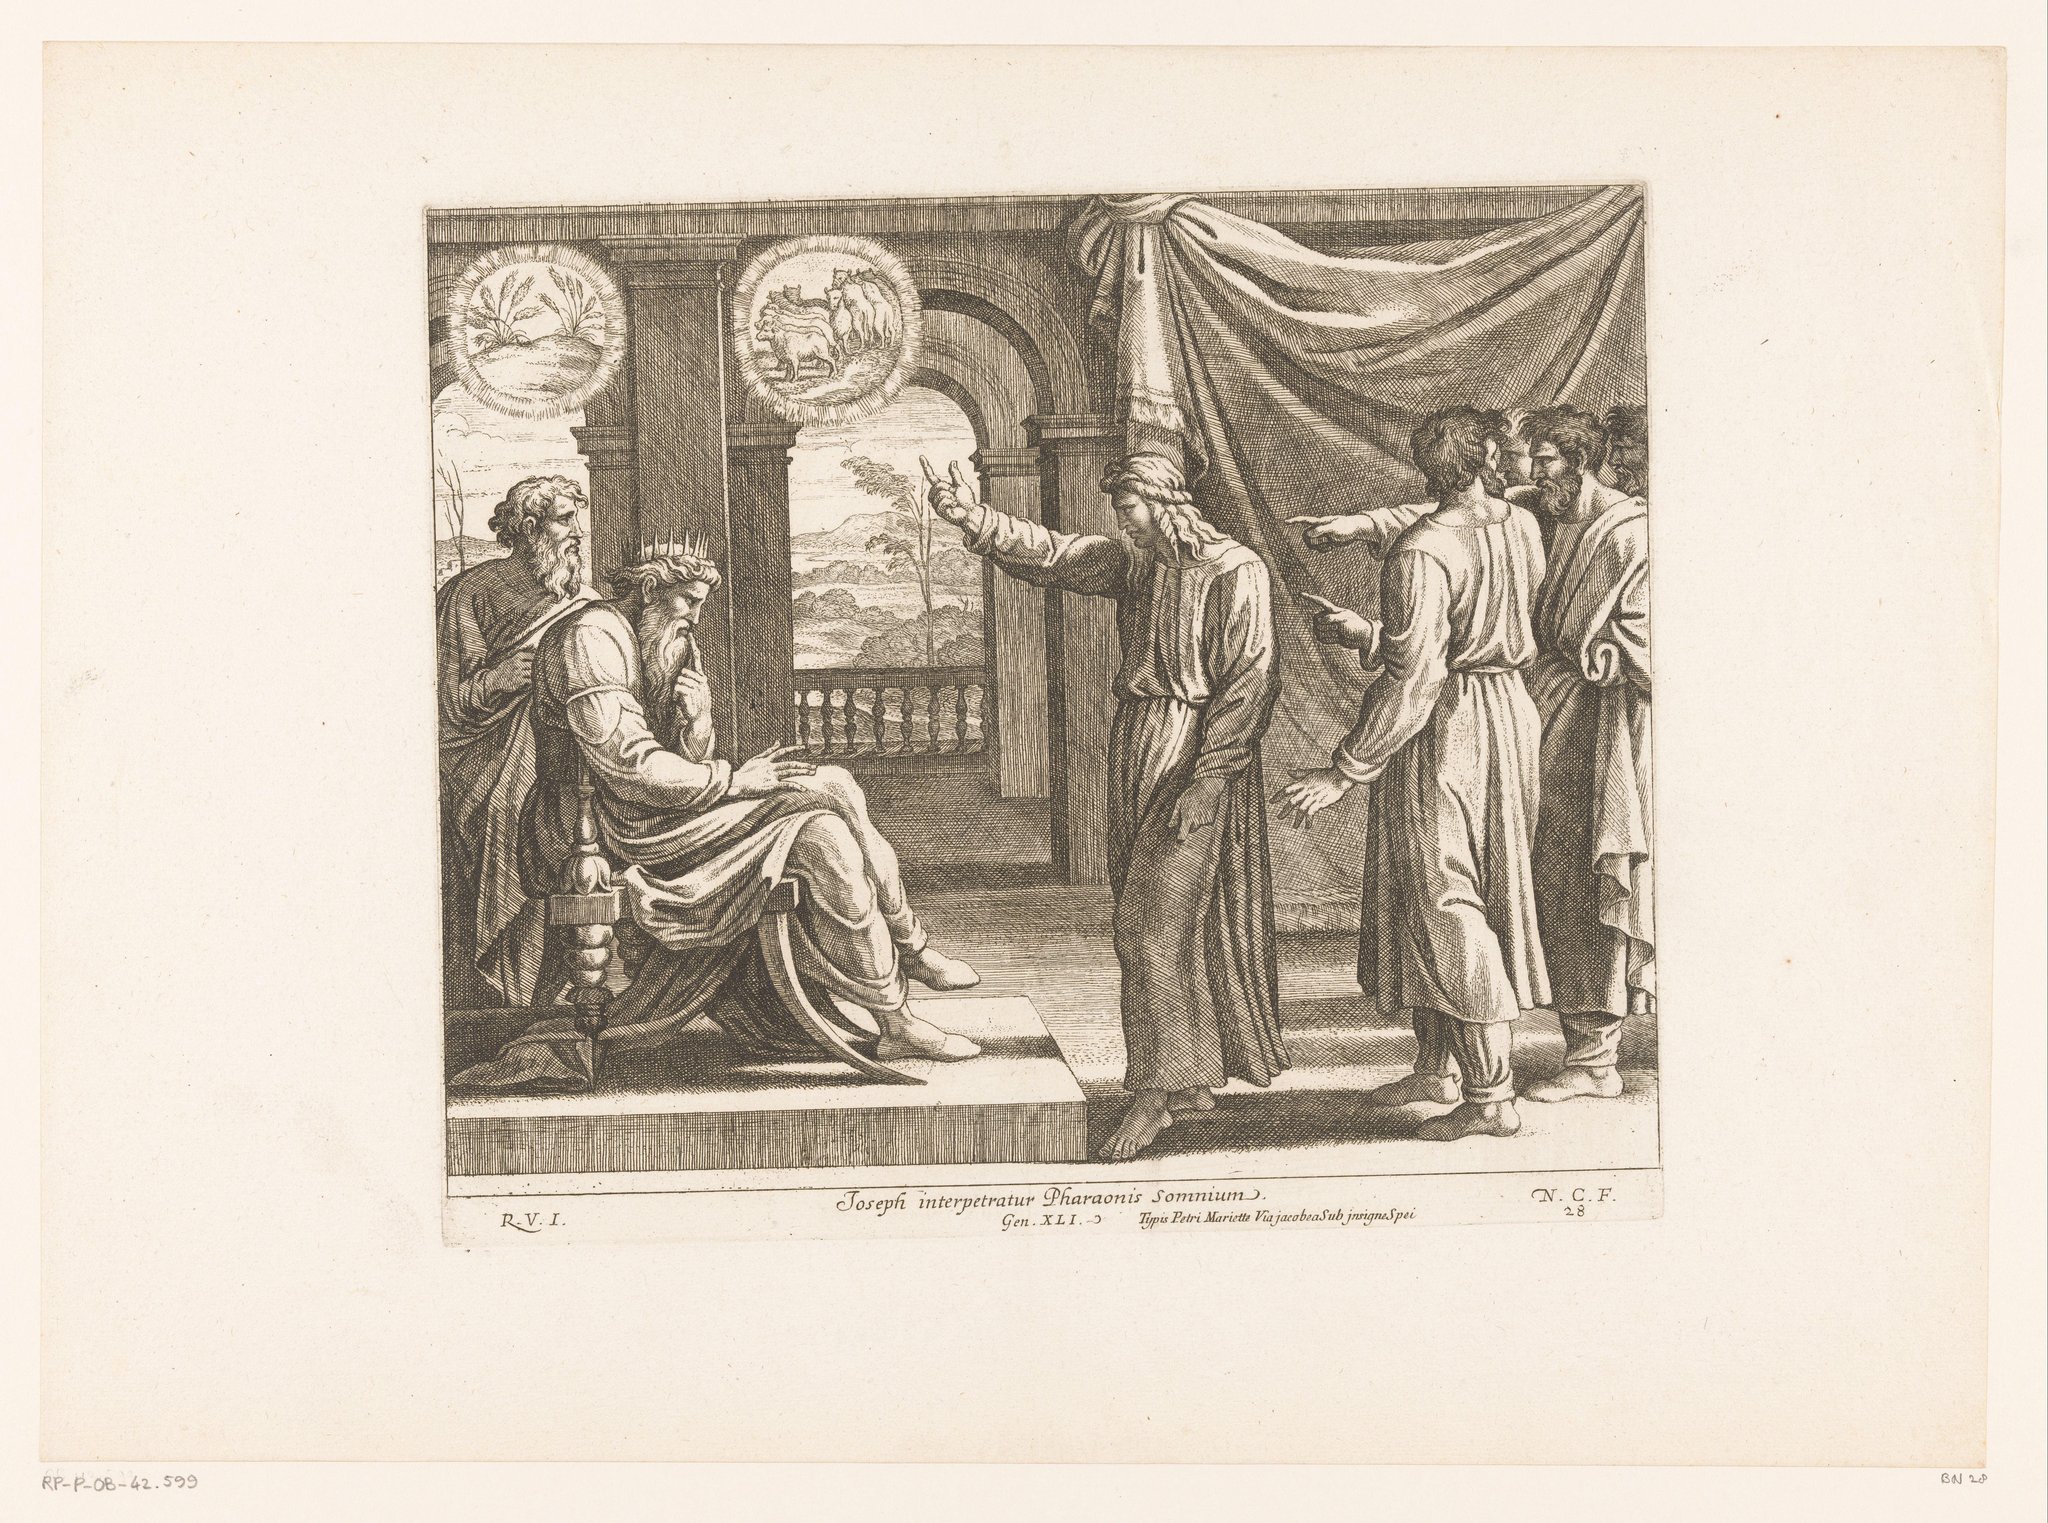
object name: print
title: Rafaël Bijbel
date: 1649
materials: paper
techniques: etching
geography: france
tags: first dream of pharaoh: seven fat cows are devoured by seven lean cows ~ story of joseph, joseph interpreting pharaoh's dreams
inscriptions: collector's mark: Lugt 2228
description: Prent uit de Sacrae Historiae Acta a Raphael Urbin in Vaticanis xystis ad picturae miraculum expressa, ook bekend als de Rafaël Bijbel. De serie bestaat uit 54 platen, waarvan twee titelprenten, de eerste met een opdracht aan Rafaël, de tweede met een opdracht aan Renard. De overige 52 platen betreffen composities naar schilderingen in de Loggia van Rafaël in het Vaticaan. De serie werd in 1649 uitgegeven door Pierre Mariette te Parijs.